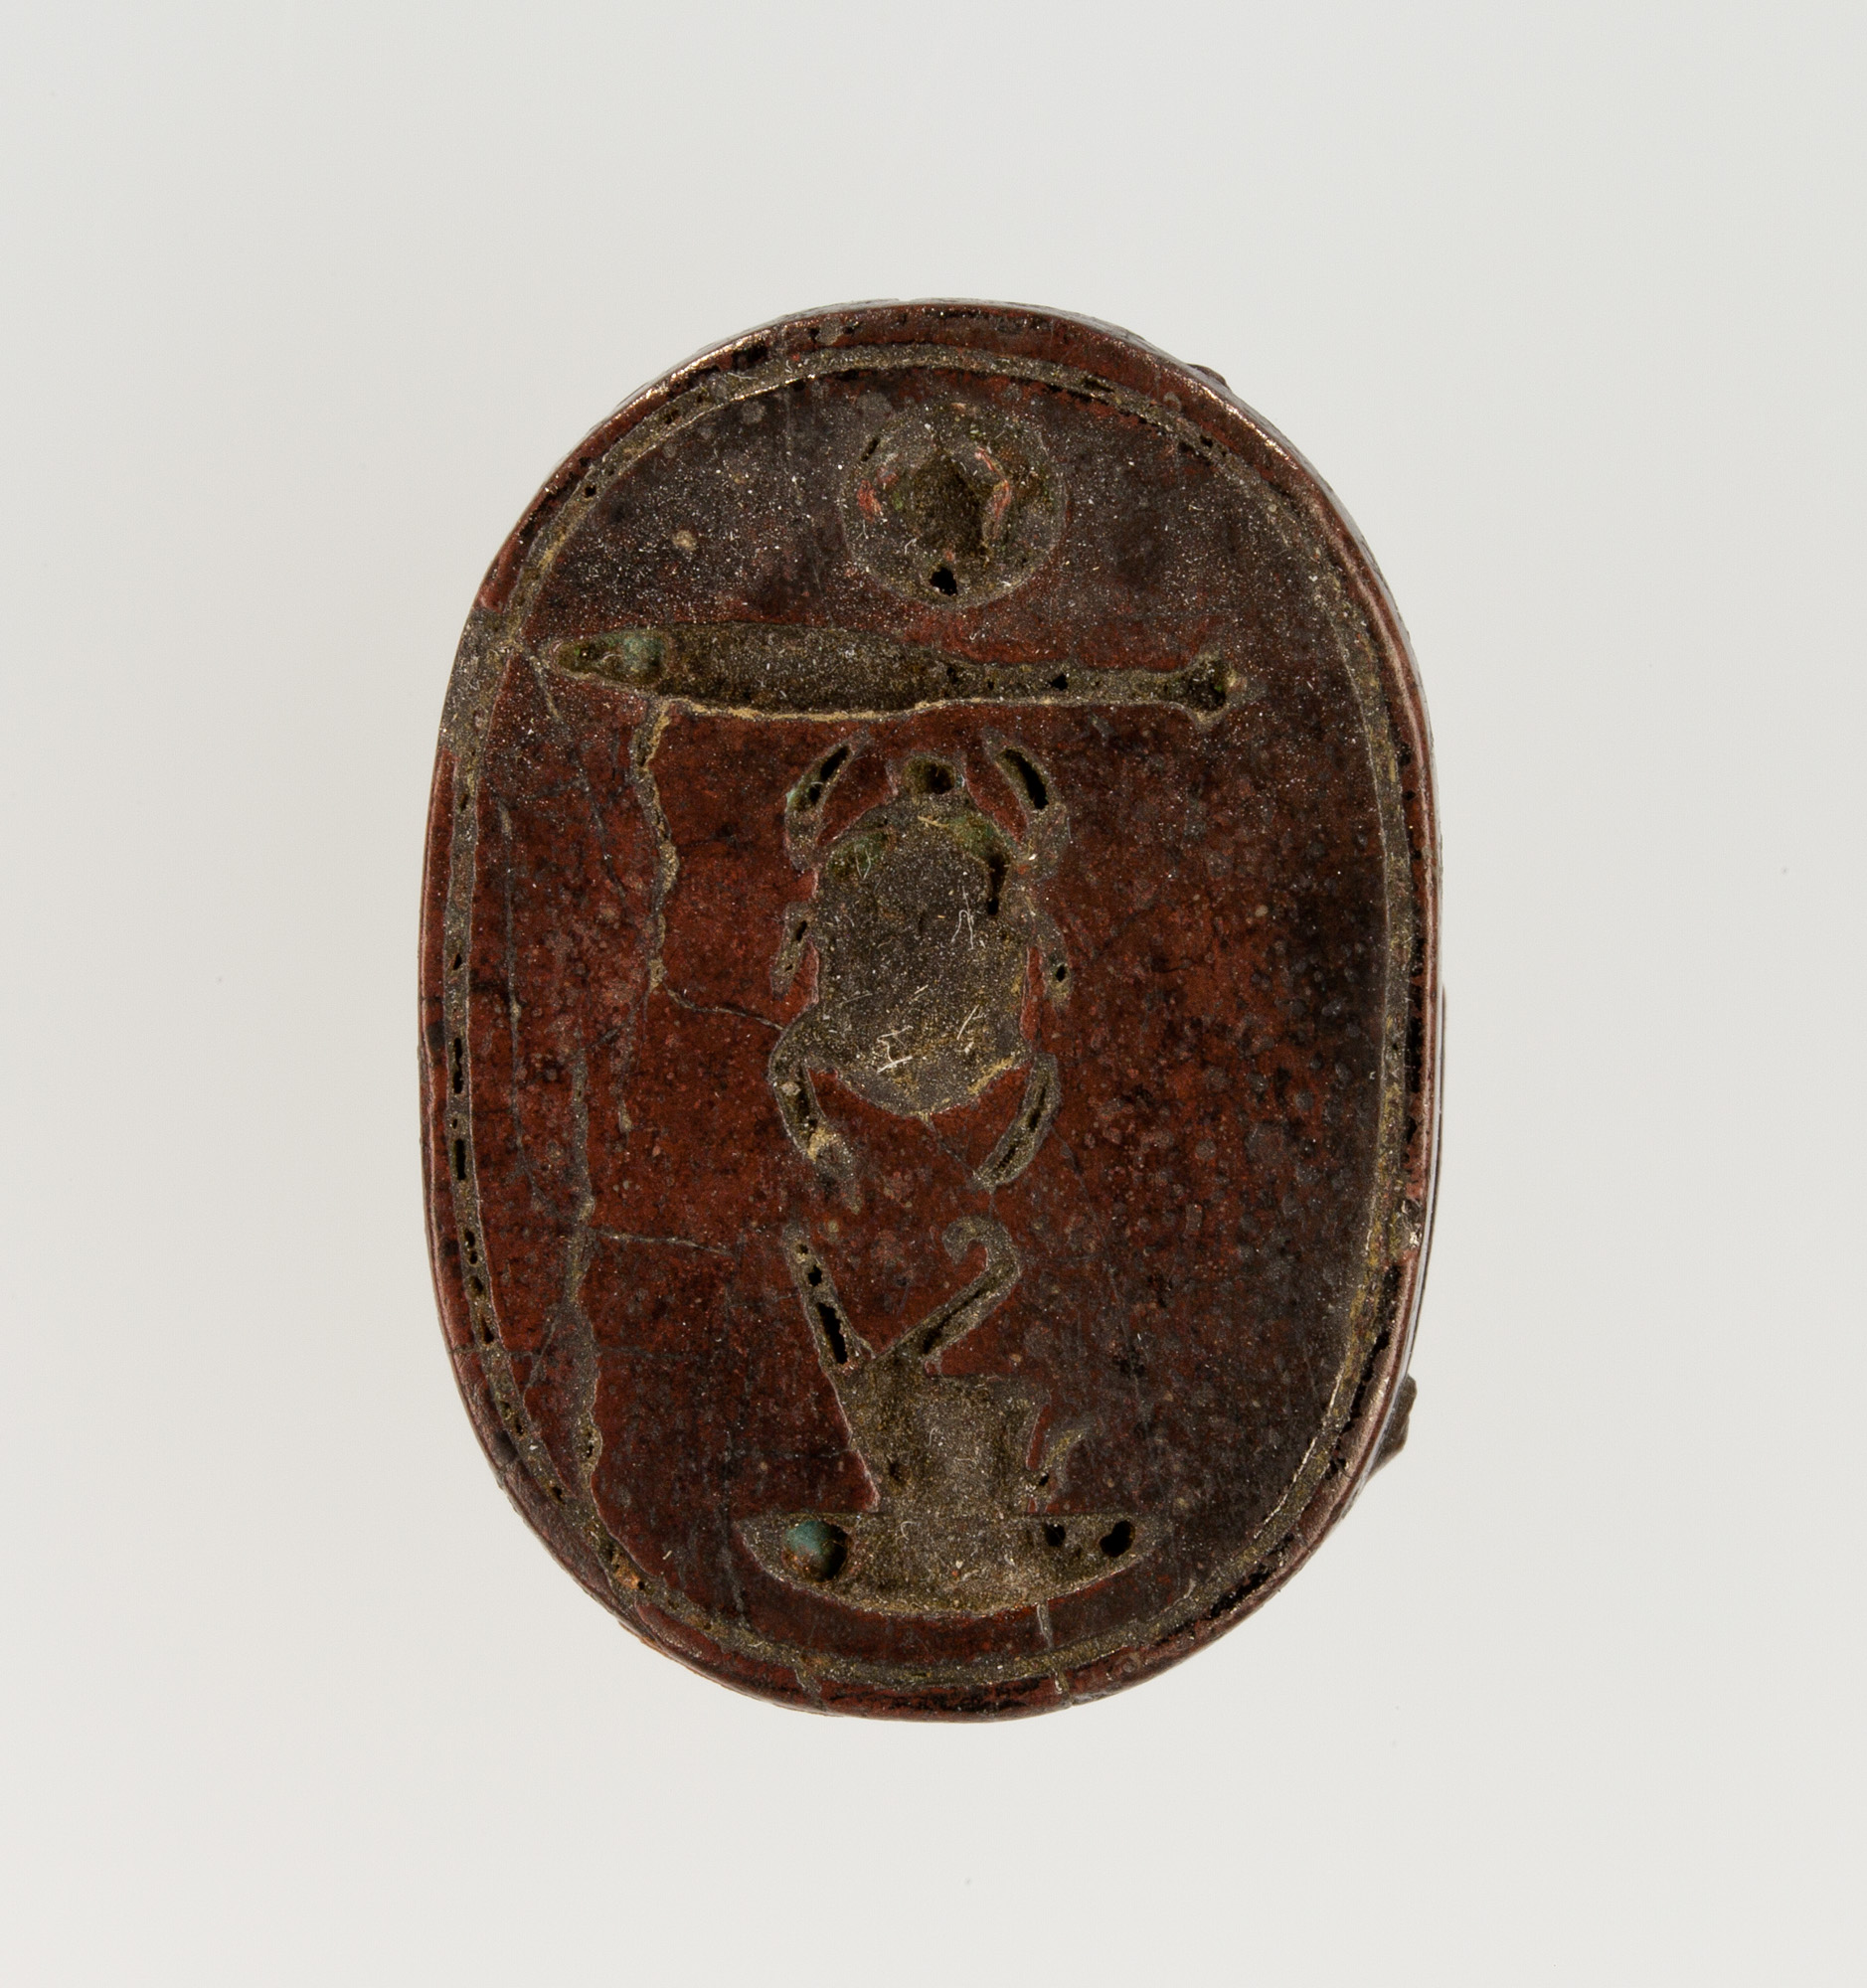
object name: scarab, thutmose ii, aakheperenre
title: Scarab Inscribed with the Throne Name of Thutmose II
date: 1492-1479 BCE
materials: mineral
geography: egypt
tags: crabs,scarabs